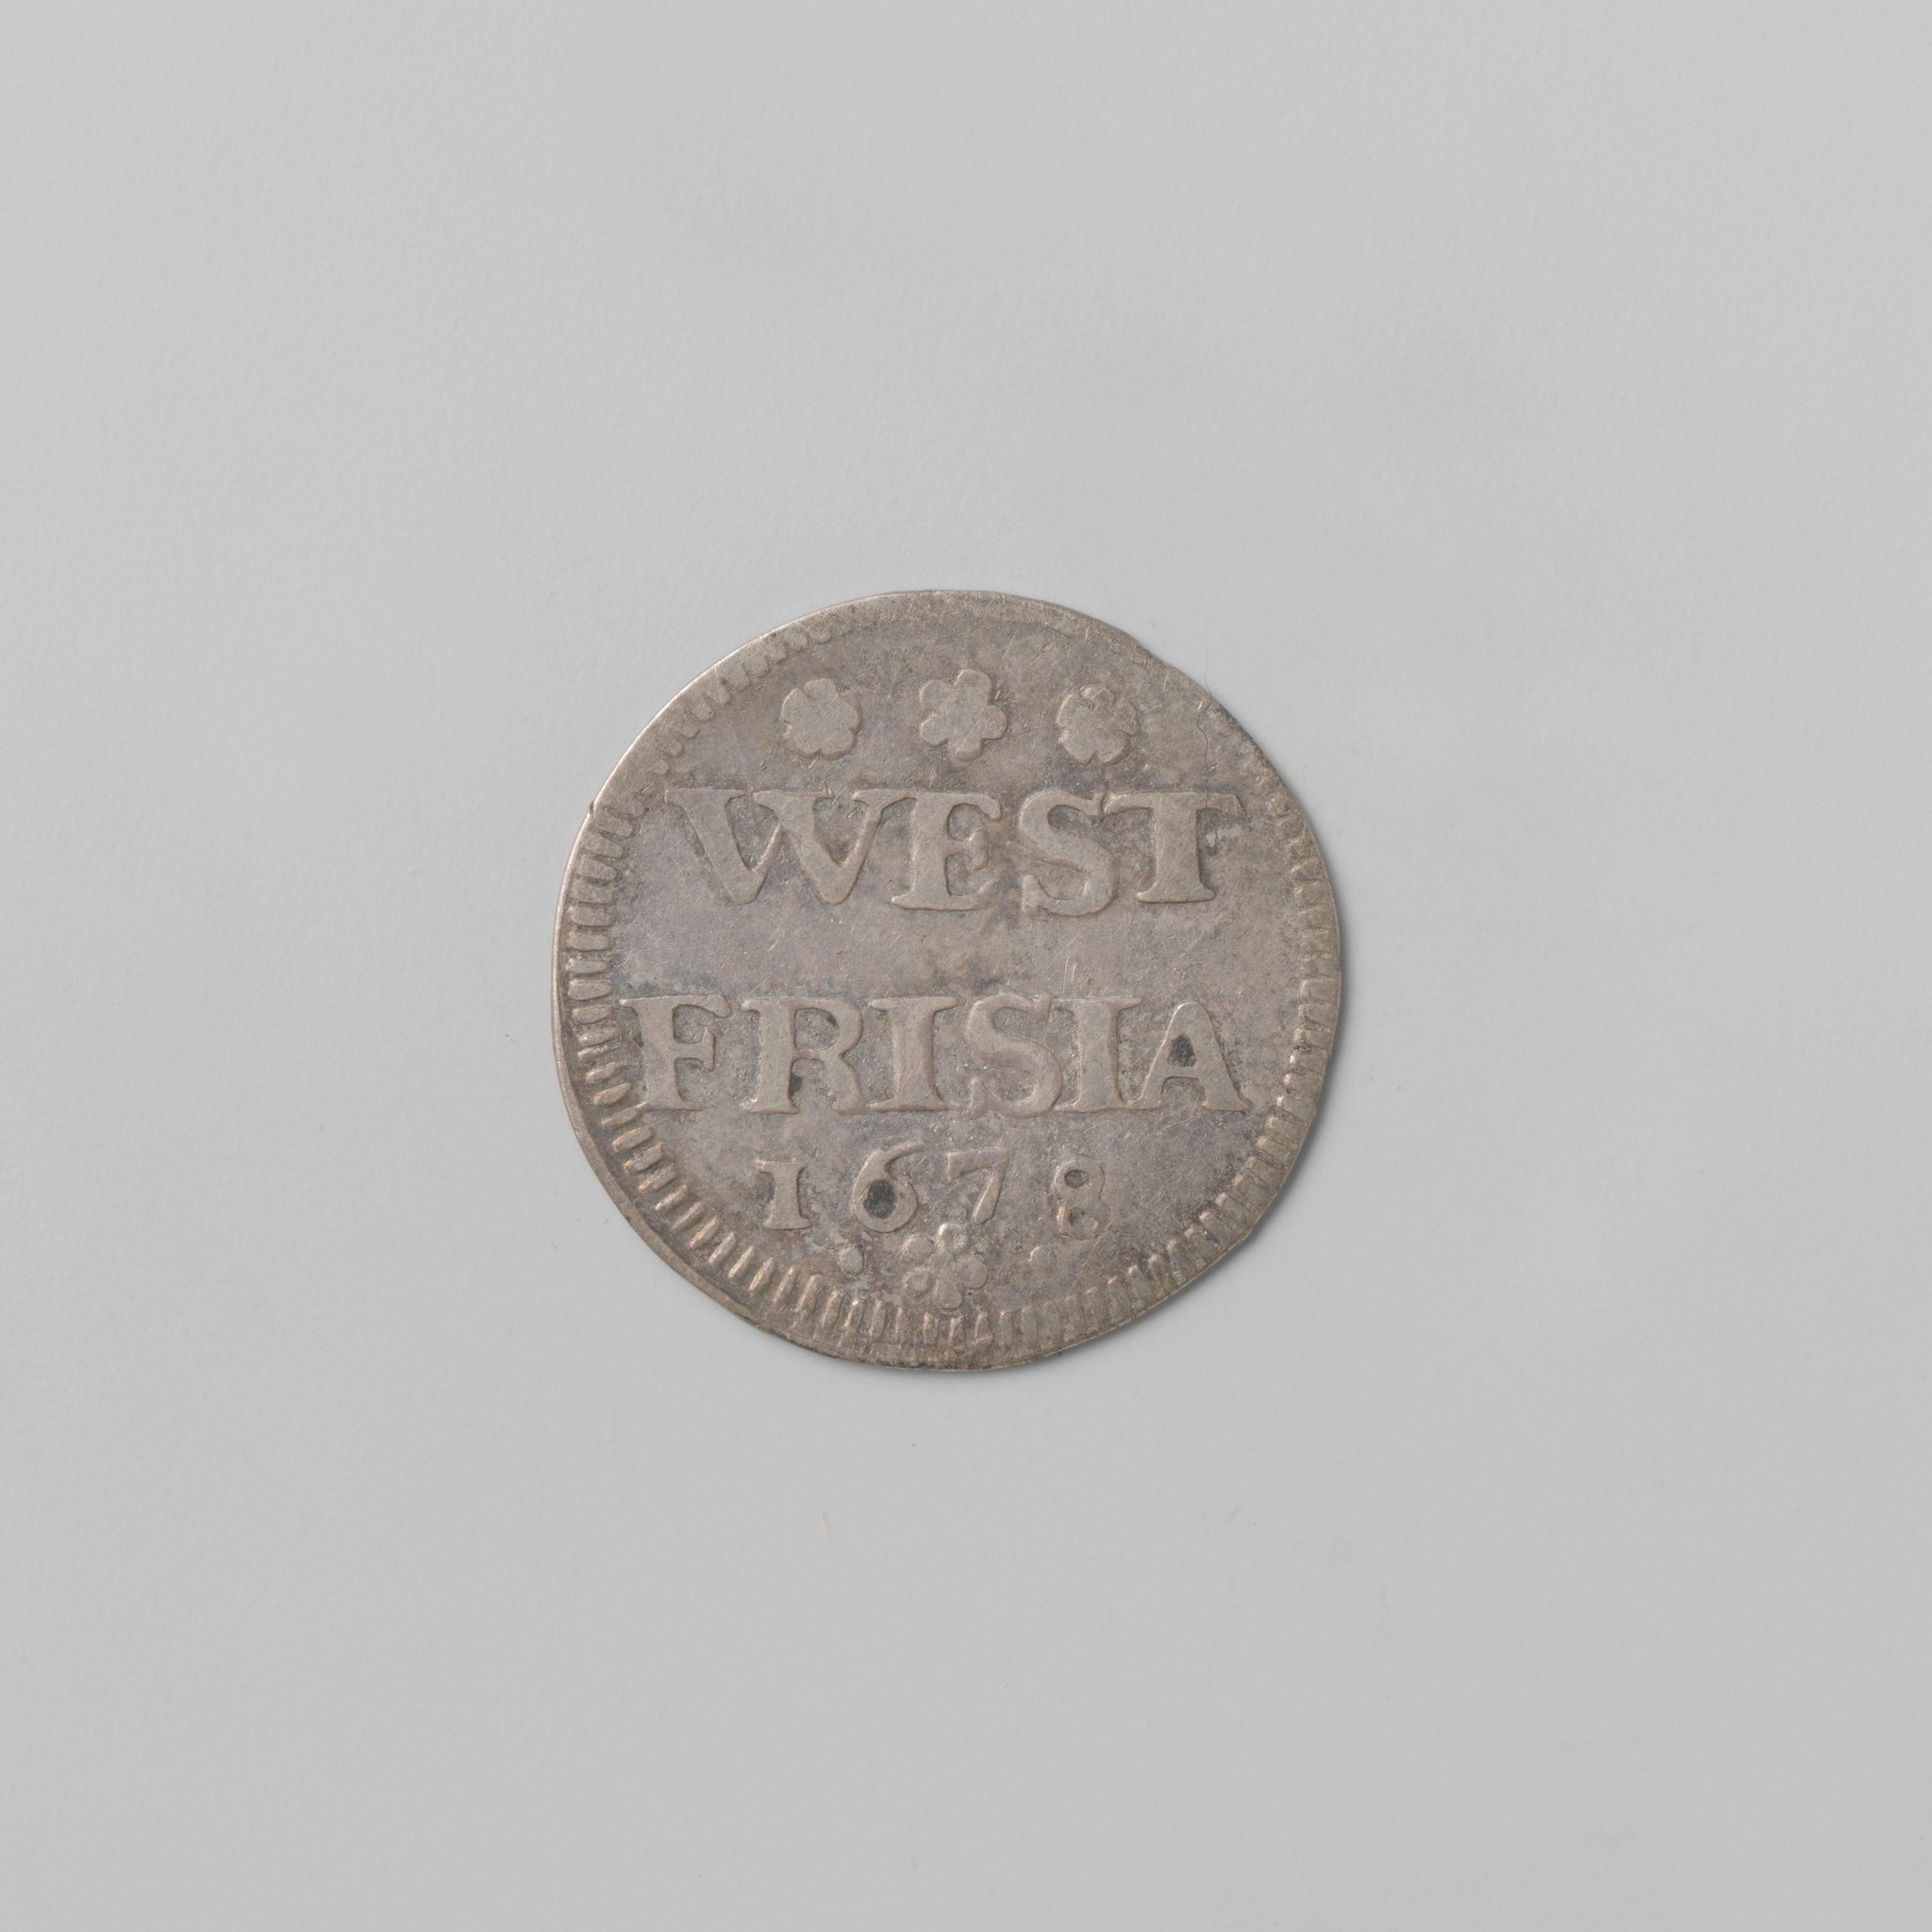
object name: coin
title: Westfriese dubbele stuiver, 1678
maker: dirck bosch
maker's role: mintmaster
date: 1678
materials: silver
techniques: striking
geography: enkhuizen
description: Zilveren munt. Voorzijde: tussen waarde-aanduiding 2 S gekroond wapenschild van West-Friesland. Keerzijde: Opschrift in twee regels.Daaronder jaartal en een rozet tussen twee punten. Daarboven drie rozetten.